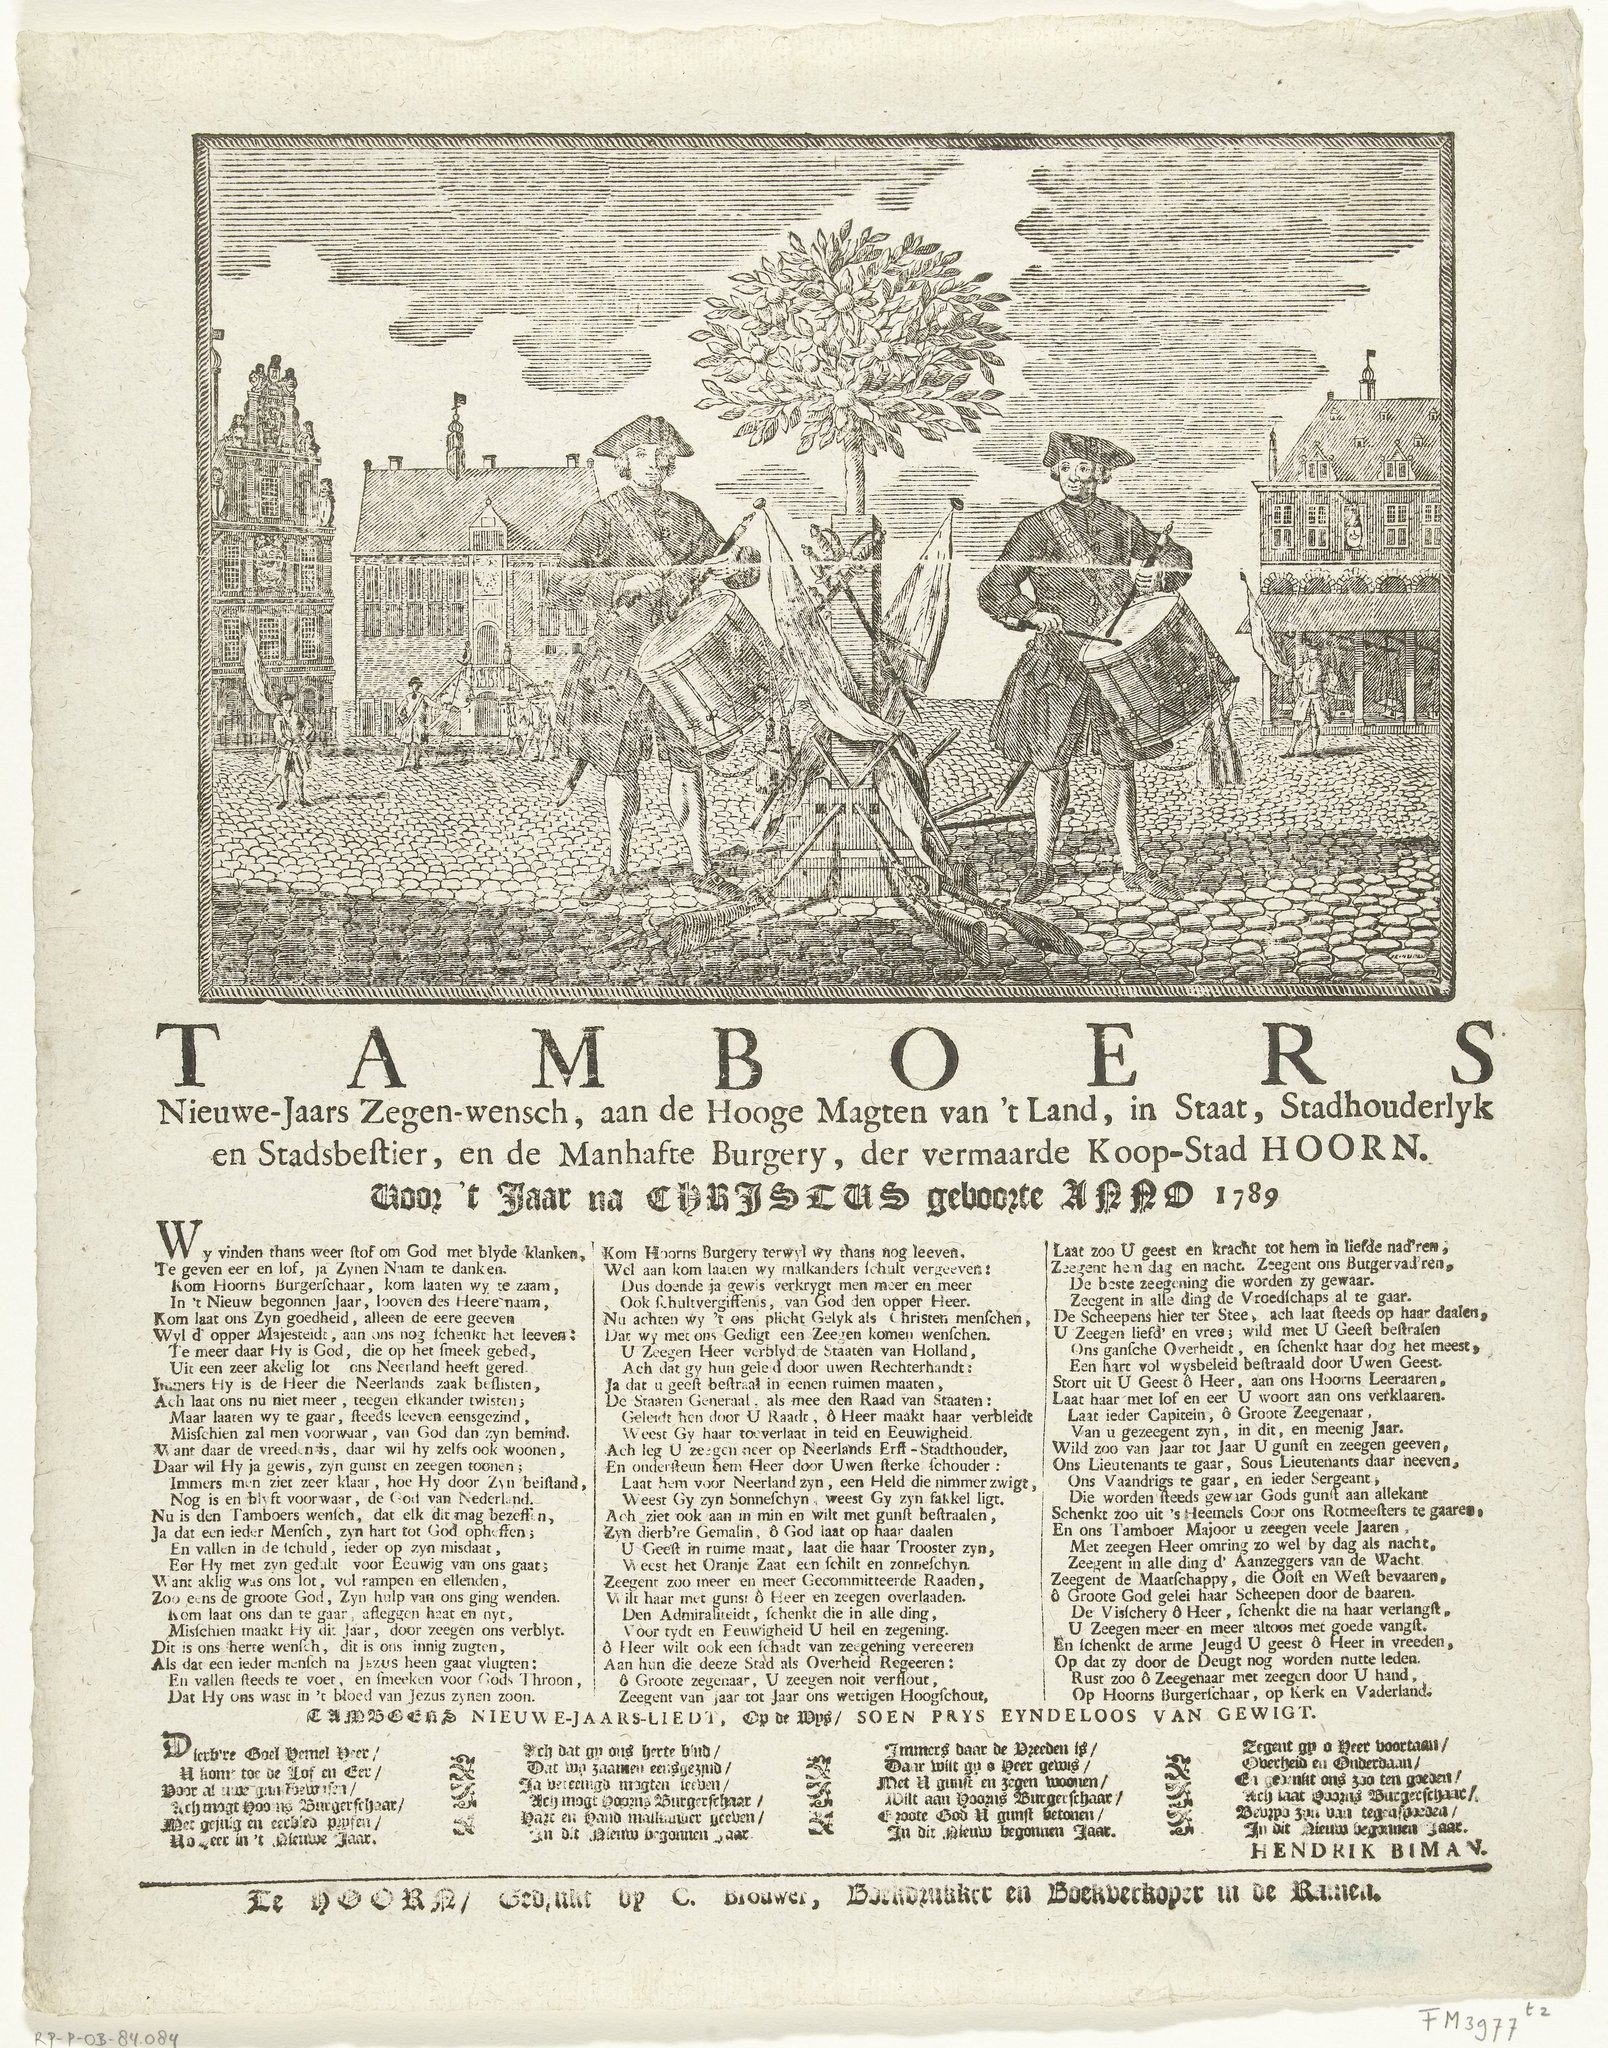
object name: popular print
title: Nieuwjaarsprent van de Hoornse tamboers voor het jaar 1789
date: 1788-1789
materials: paper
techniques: letterpress printing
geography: hoorn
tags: drum (musical instrument) - cc - out of doors, hoorn (north holland)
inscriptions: collector's mark: Lugt 2228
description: Nieuwjaarsprent van de tamboers van de stad Hoorn voor het jaar 1789. Opgedragen aan het stadsbestuur en de inwoners van Hoorn. Twee tamboers met trommels bij een Oranjeboom versierd met wapens en vaandels, op de achtergrond gebouwen te Hoorn, waaronder het Oude Stadhuis, de Waag en het Statencollege. Op het blad onder de voorstelling een vers in drie kolommen met onderaan een lied in vier kolommen van Hendrik Biman.